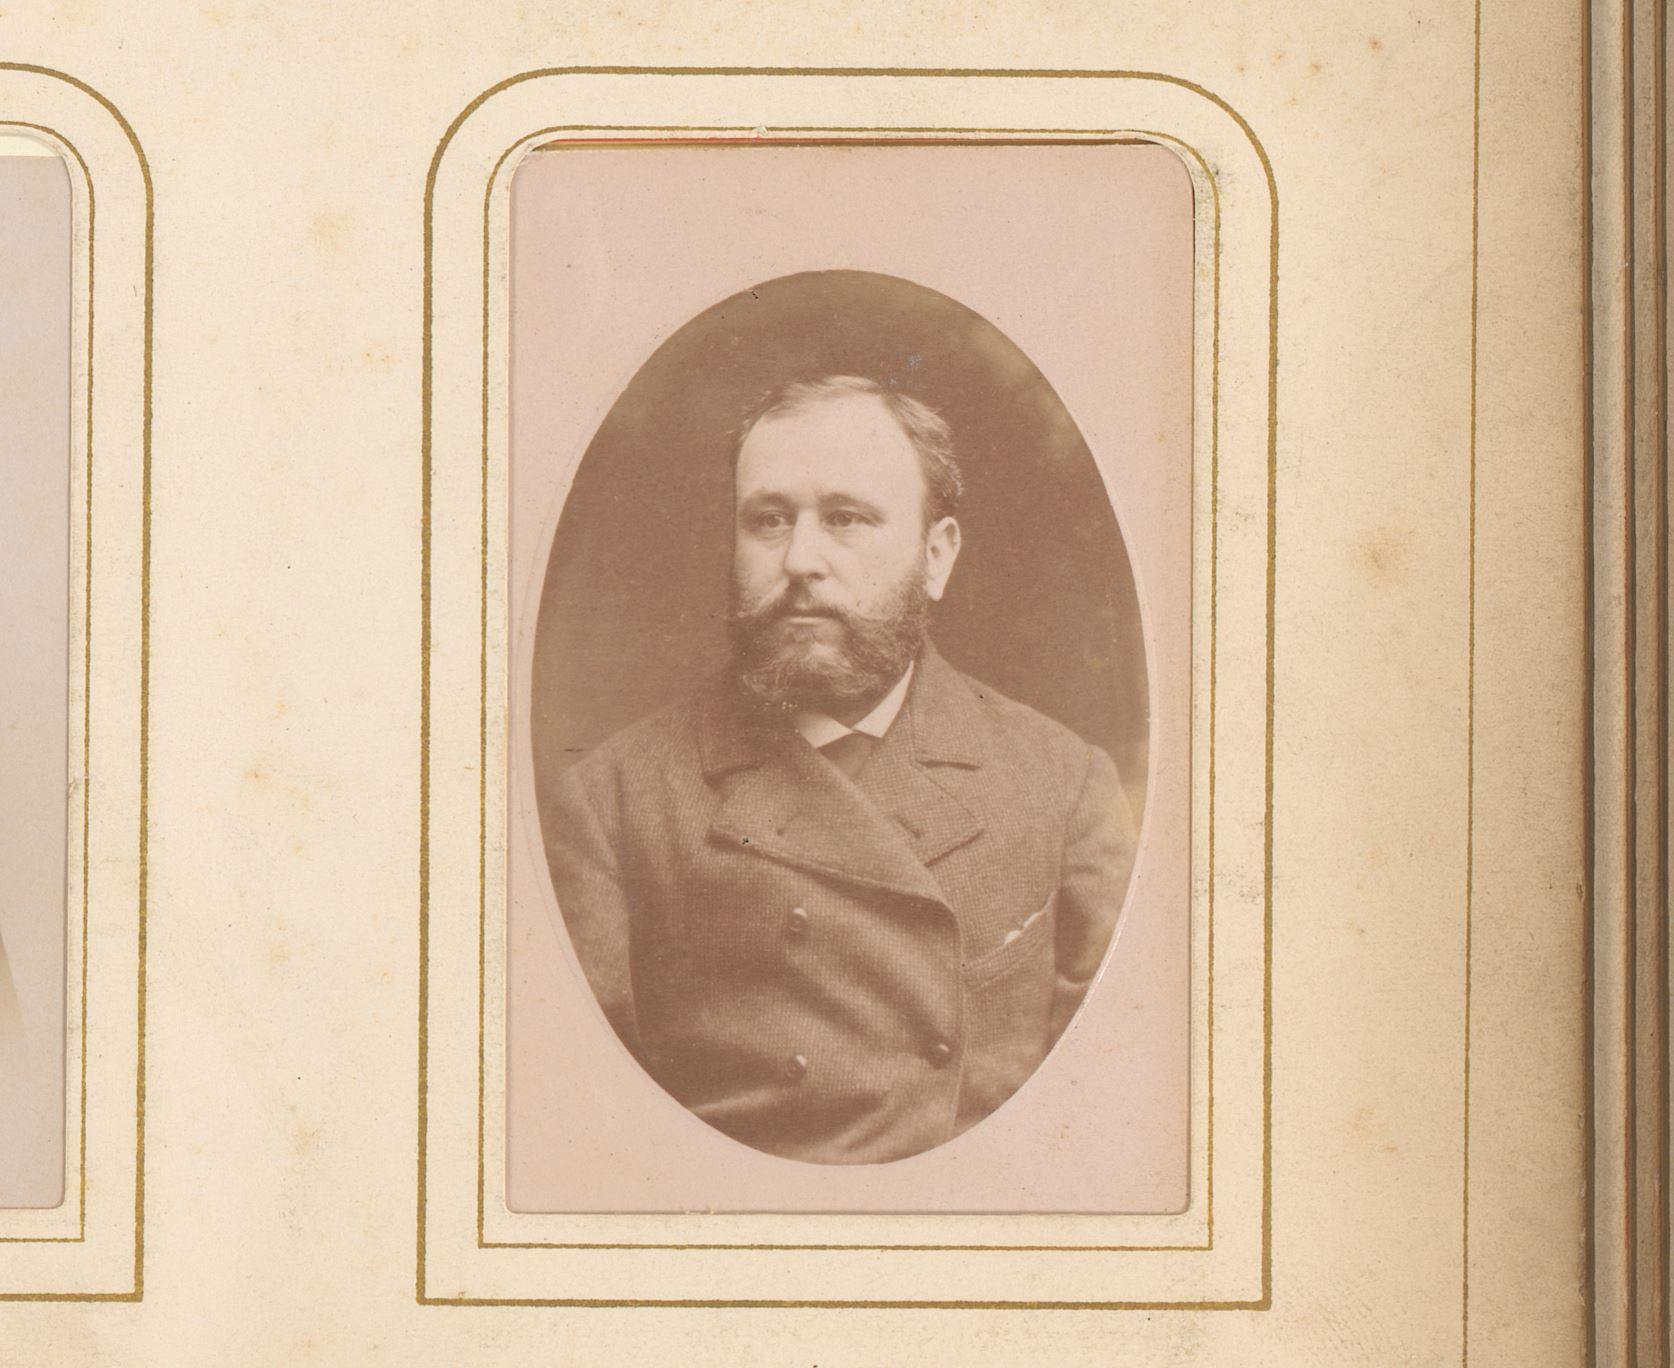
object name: carte de visite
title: Portret van een man met snor en baard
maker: andré neu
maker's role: fotograaf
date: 1879-1889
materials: cardboard, celluloid, photographic support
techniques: albumen print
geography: brussels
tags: moustache, historical persons, beard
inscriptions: inscription: ‘ATELIER DE POSE AU REZ DE CHAUSSÉE/ PHOTOGRAPH/ André Neu/ 139 Chaussée d'Ixelles 139/ IXELLES-LÈS-BRUXELLES/ Les Clichés sont conservés’